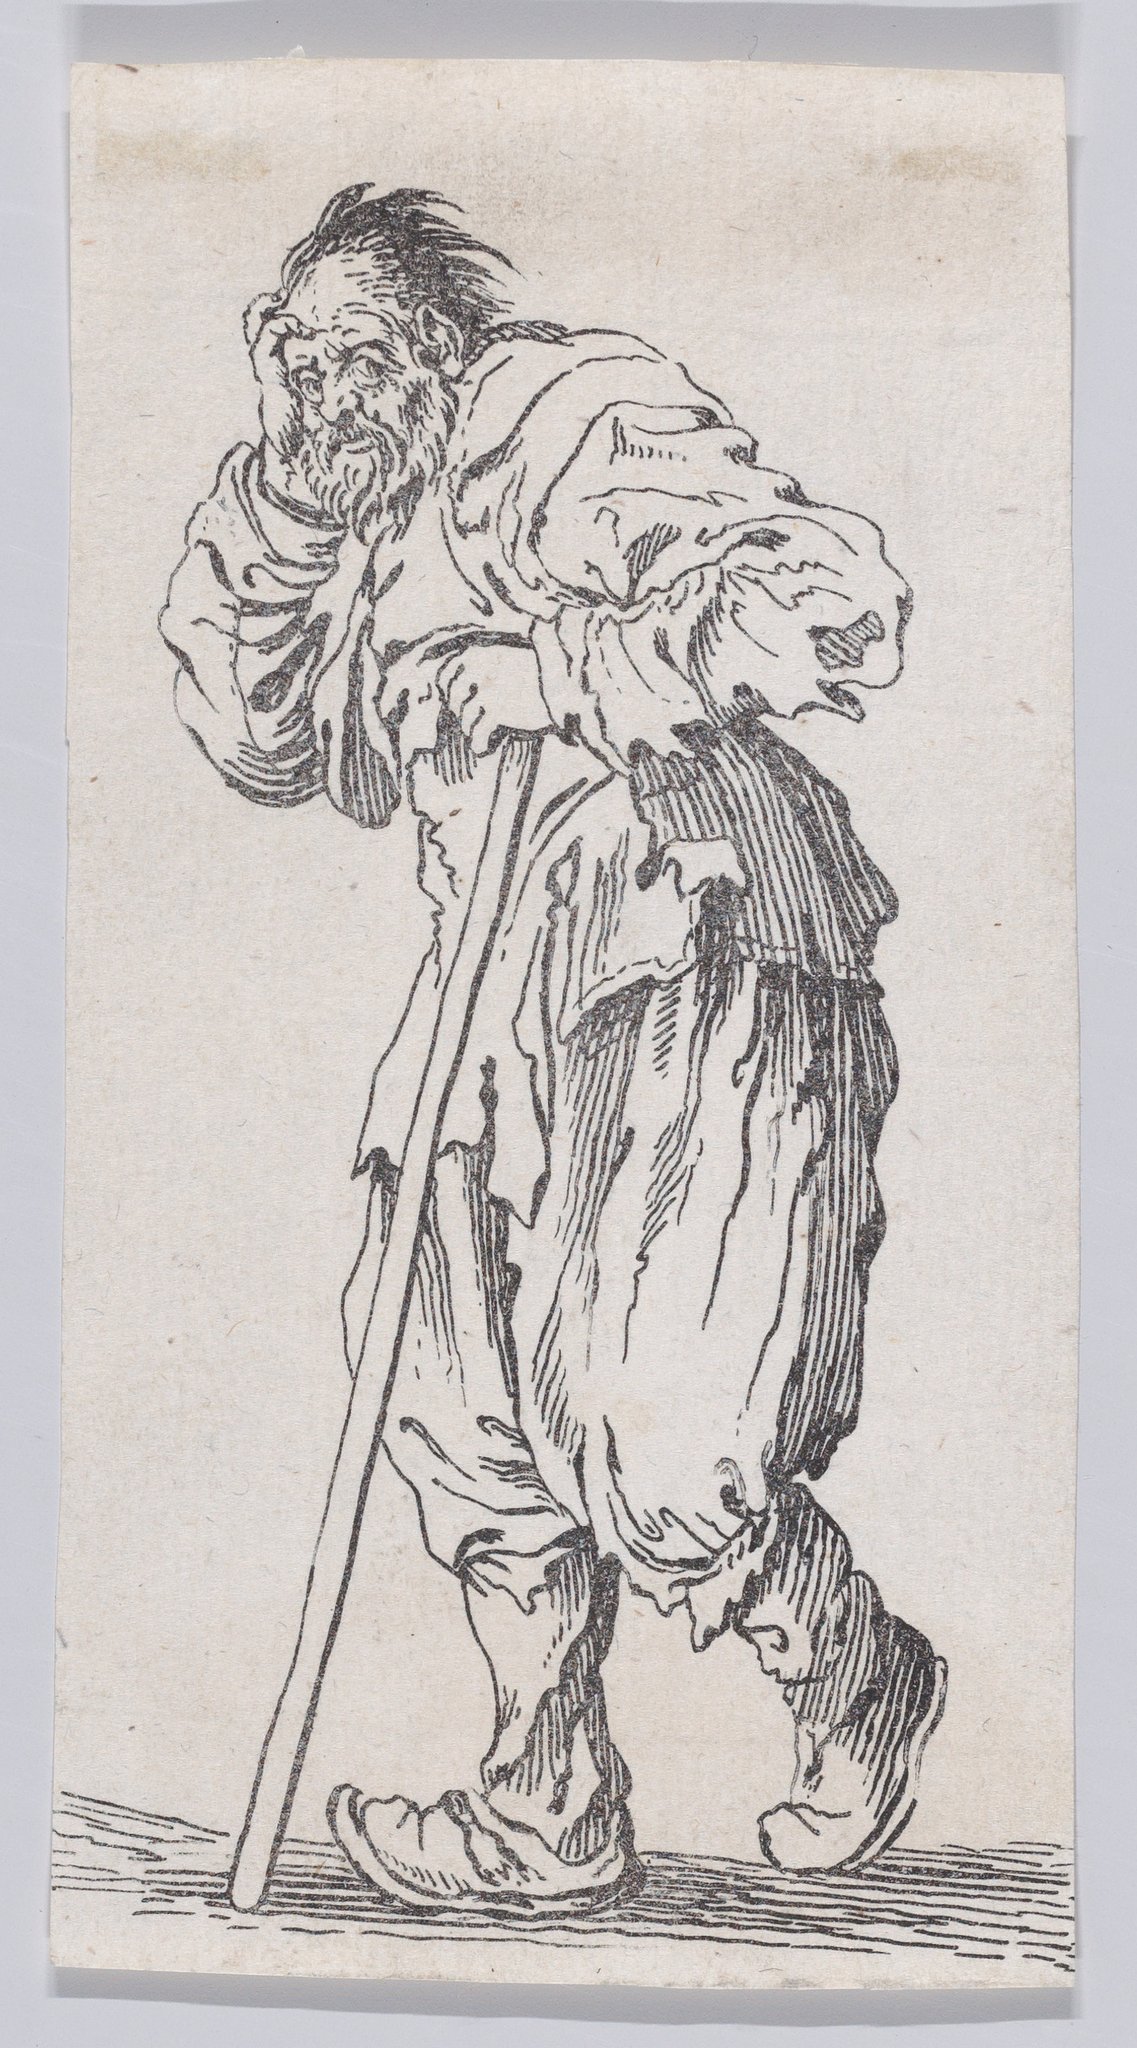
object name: print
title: Reverse Copy of Le Gueux Appuyé sur son Baton (The Beggar Leaning on His Cane), from "Les Gueux suite appelée aussi Les Mendiants, Les Baroni, ou Les Barons" (The Beggars, also called the Barons)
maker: Anonymous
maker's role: artist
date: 1601-1700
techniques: etching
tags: men